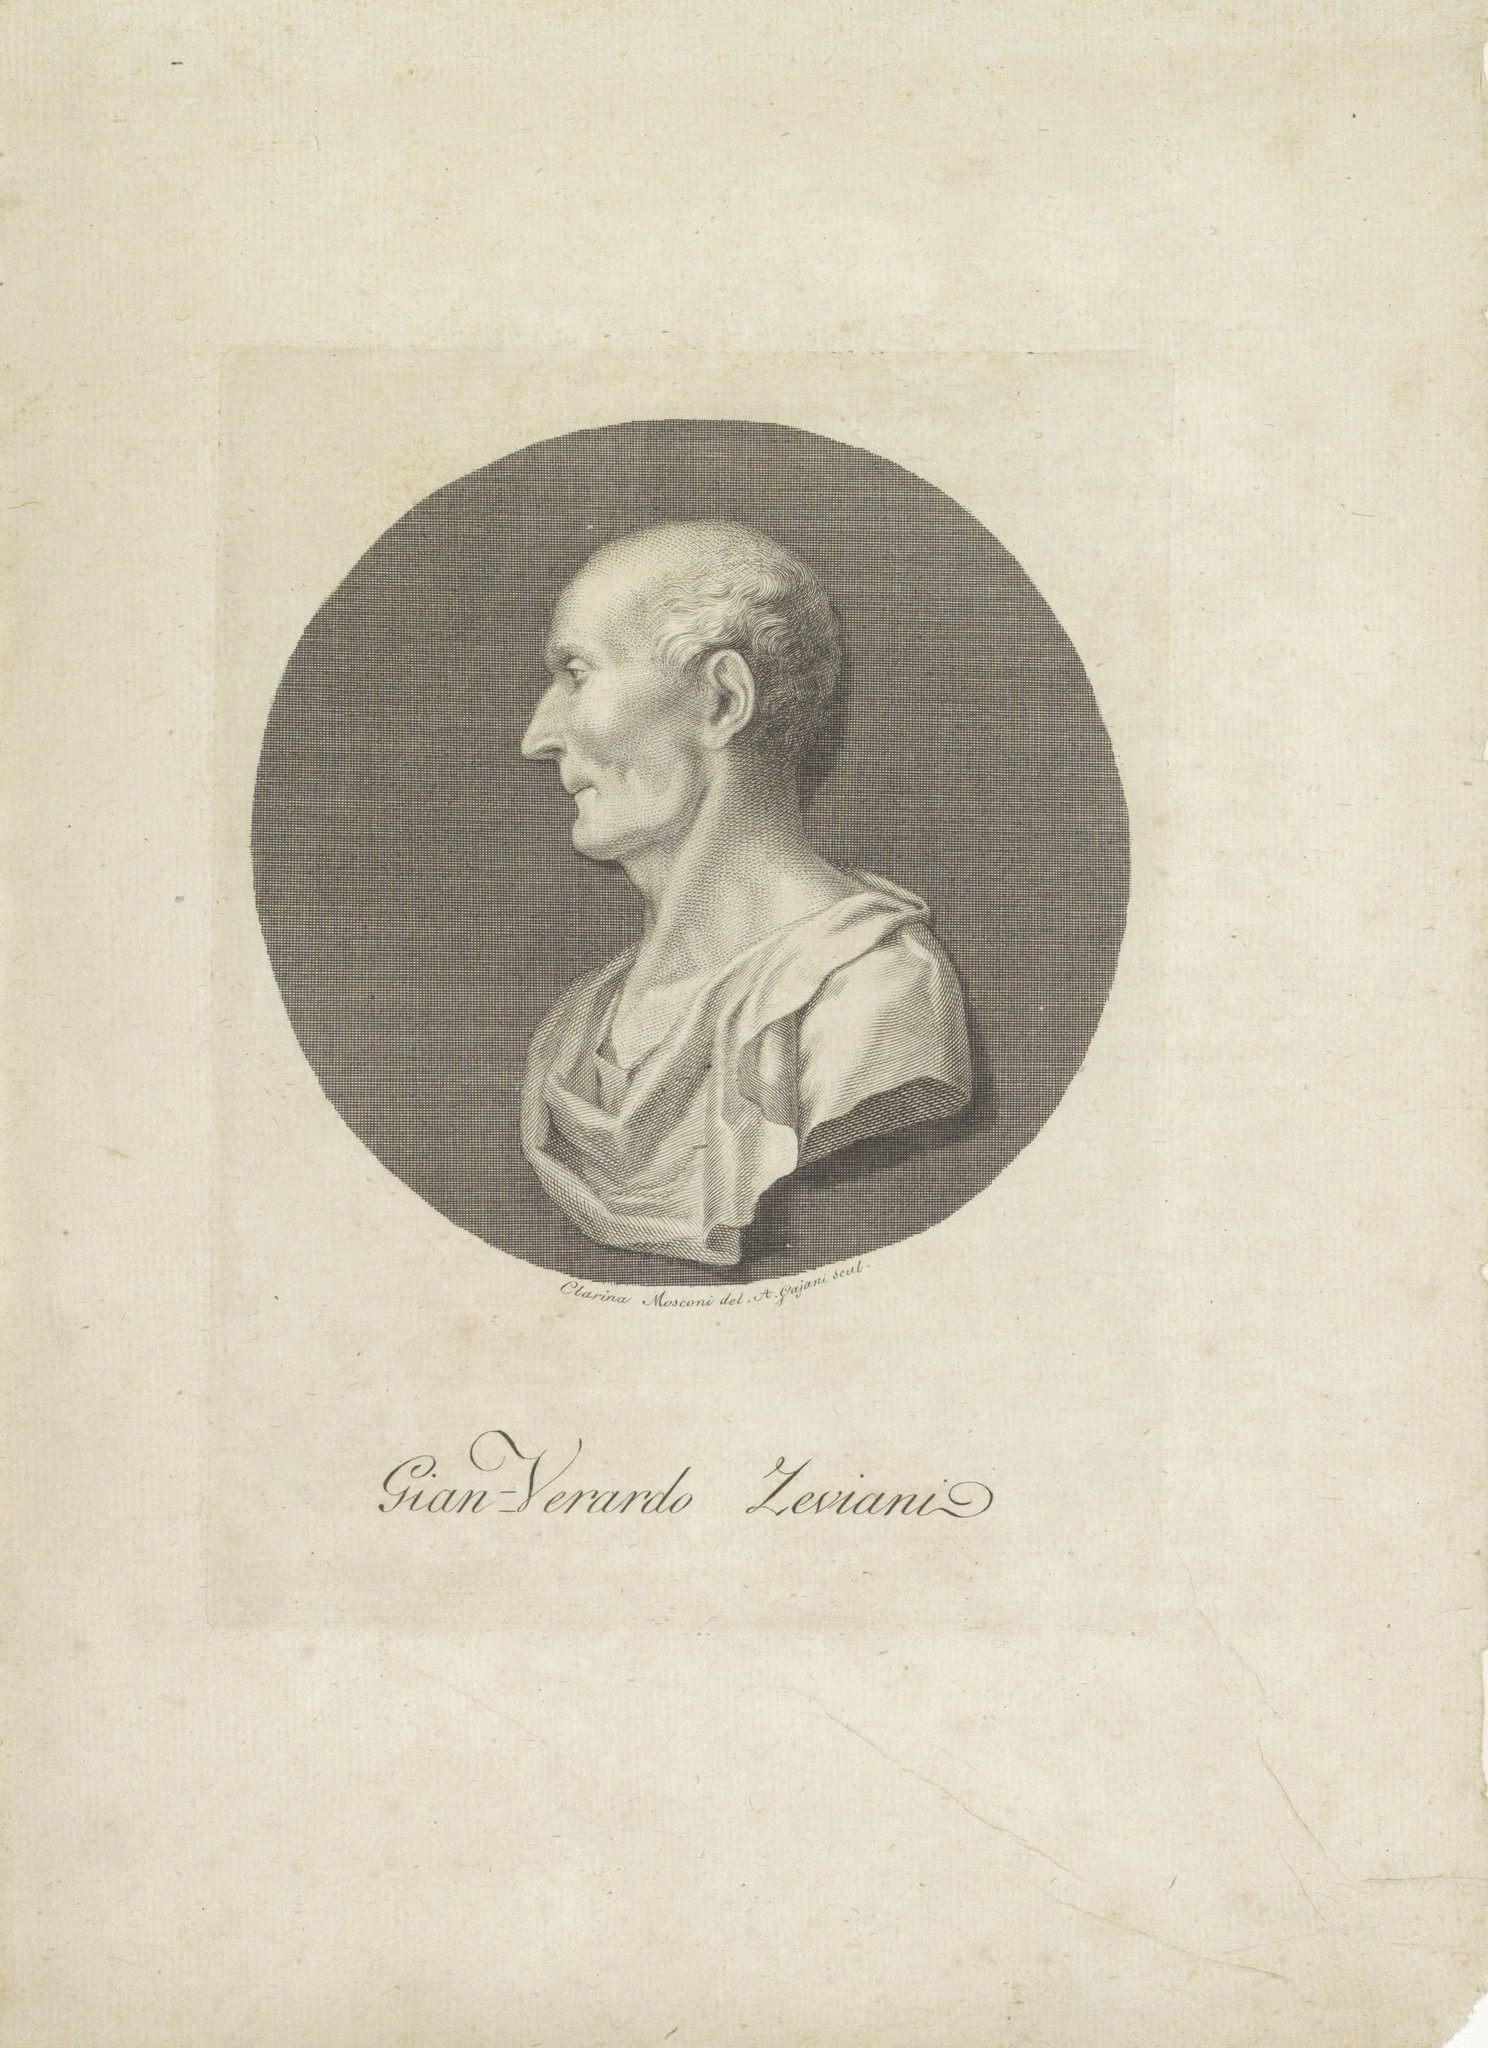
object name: print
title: Portret van medicus Giovanni Verardo Zeviani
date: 1814-1821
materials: paper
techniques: engraving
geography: italy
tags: historical persons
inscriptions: collector's mark: Lugt 2228